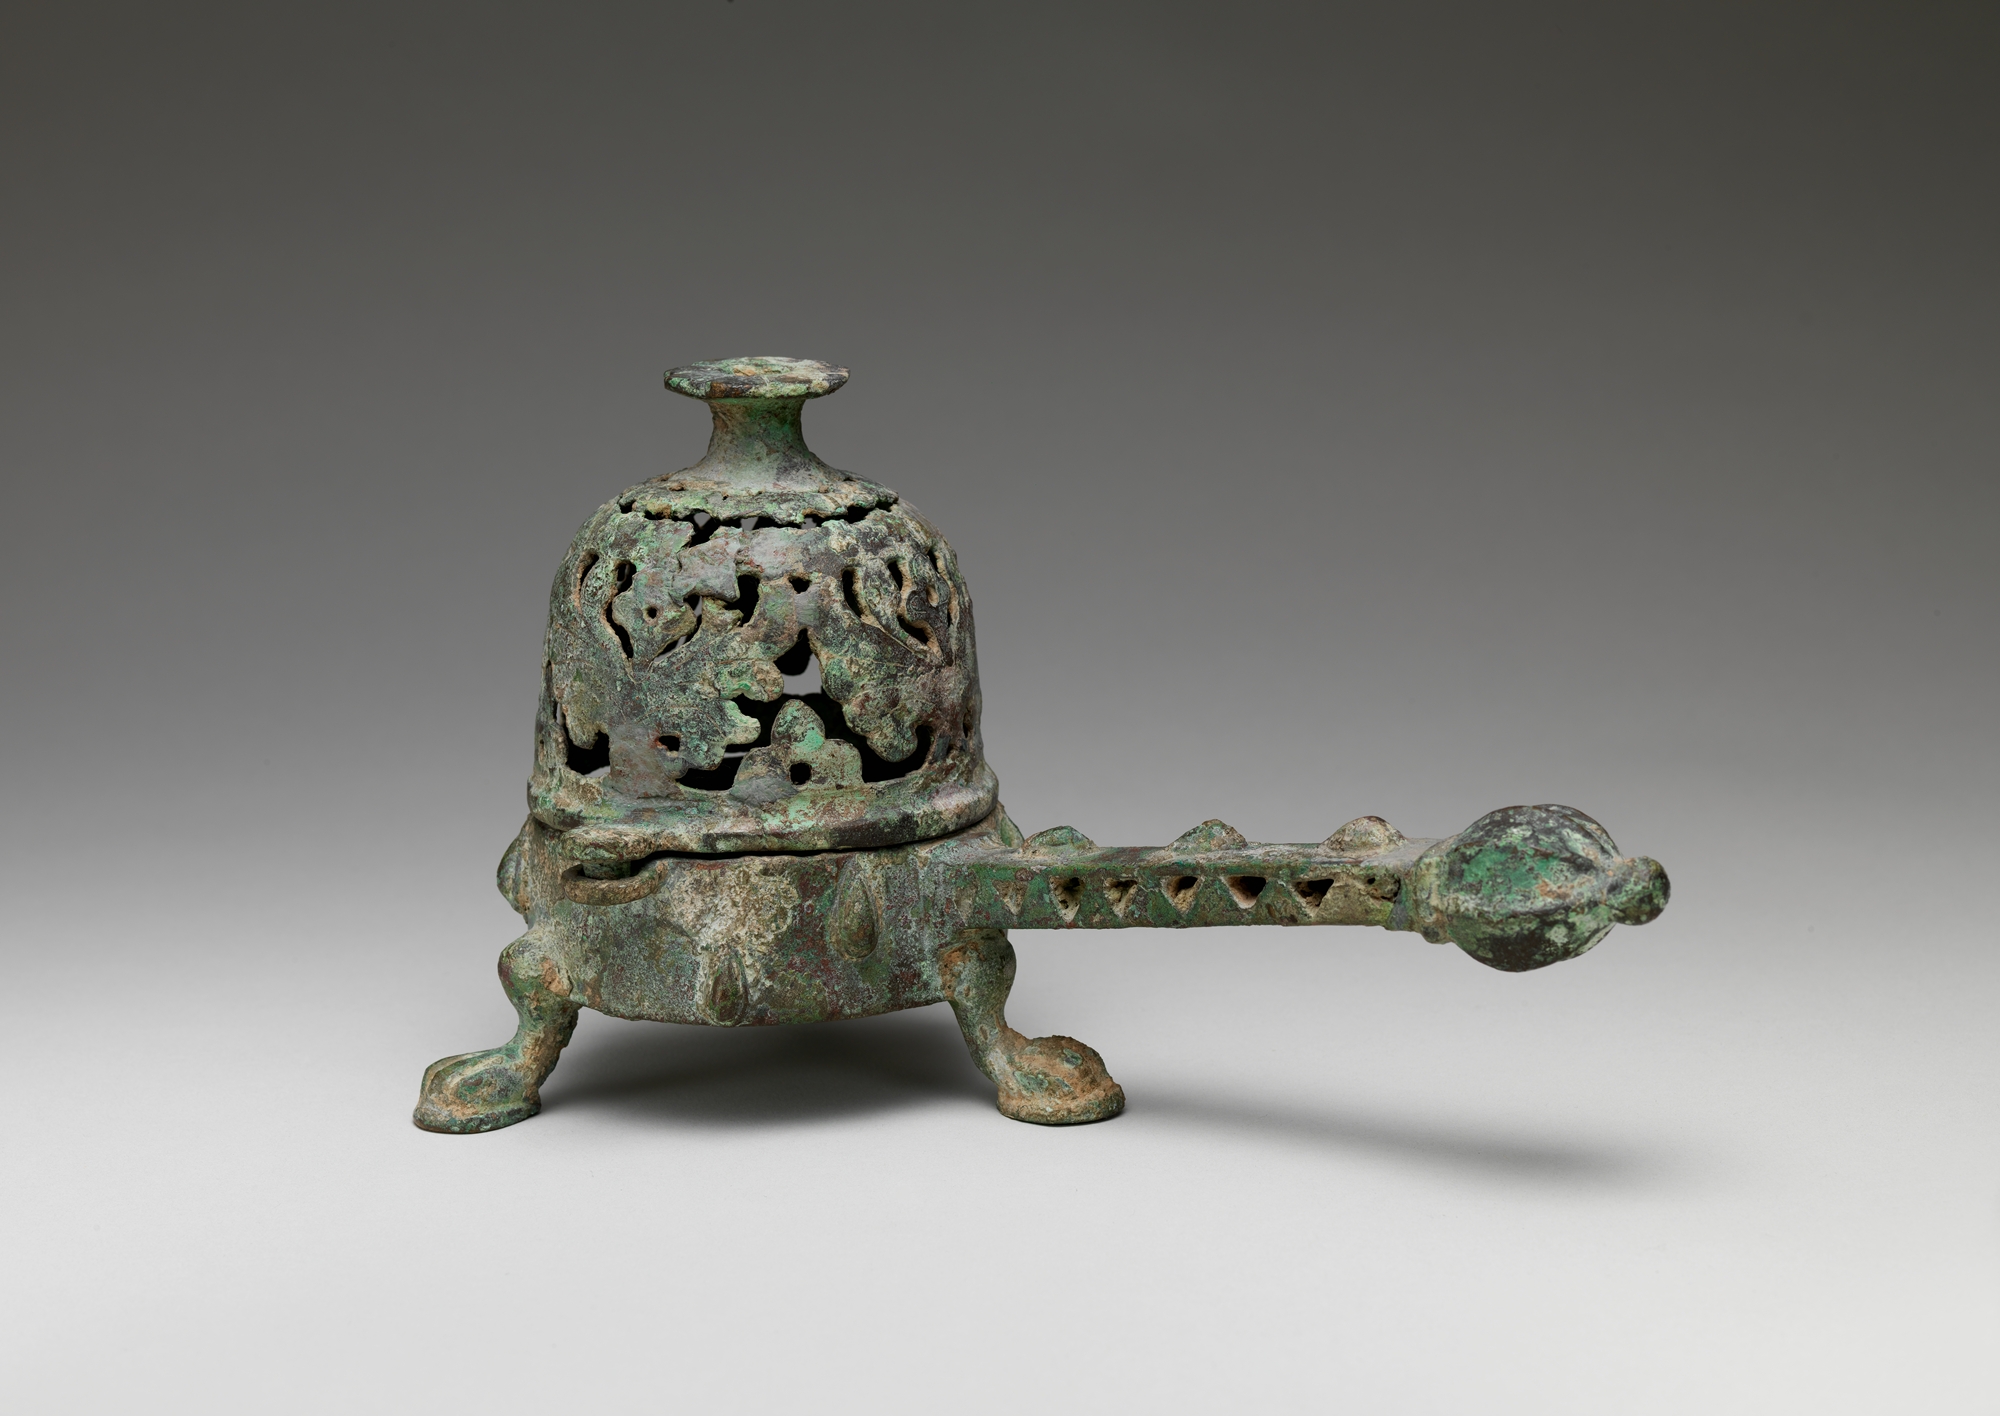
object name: incense burner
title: Incense Burner with Domed Cover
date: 701-900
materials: bronze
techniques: casting, incising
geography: iran